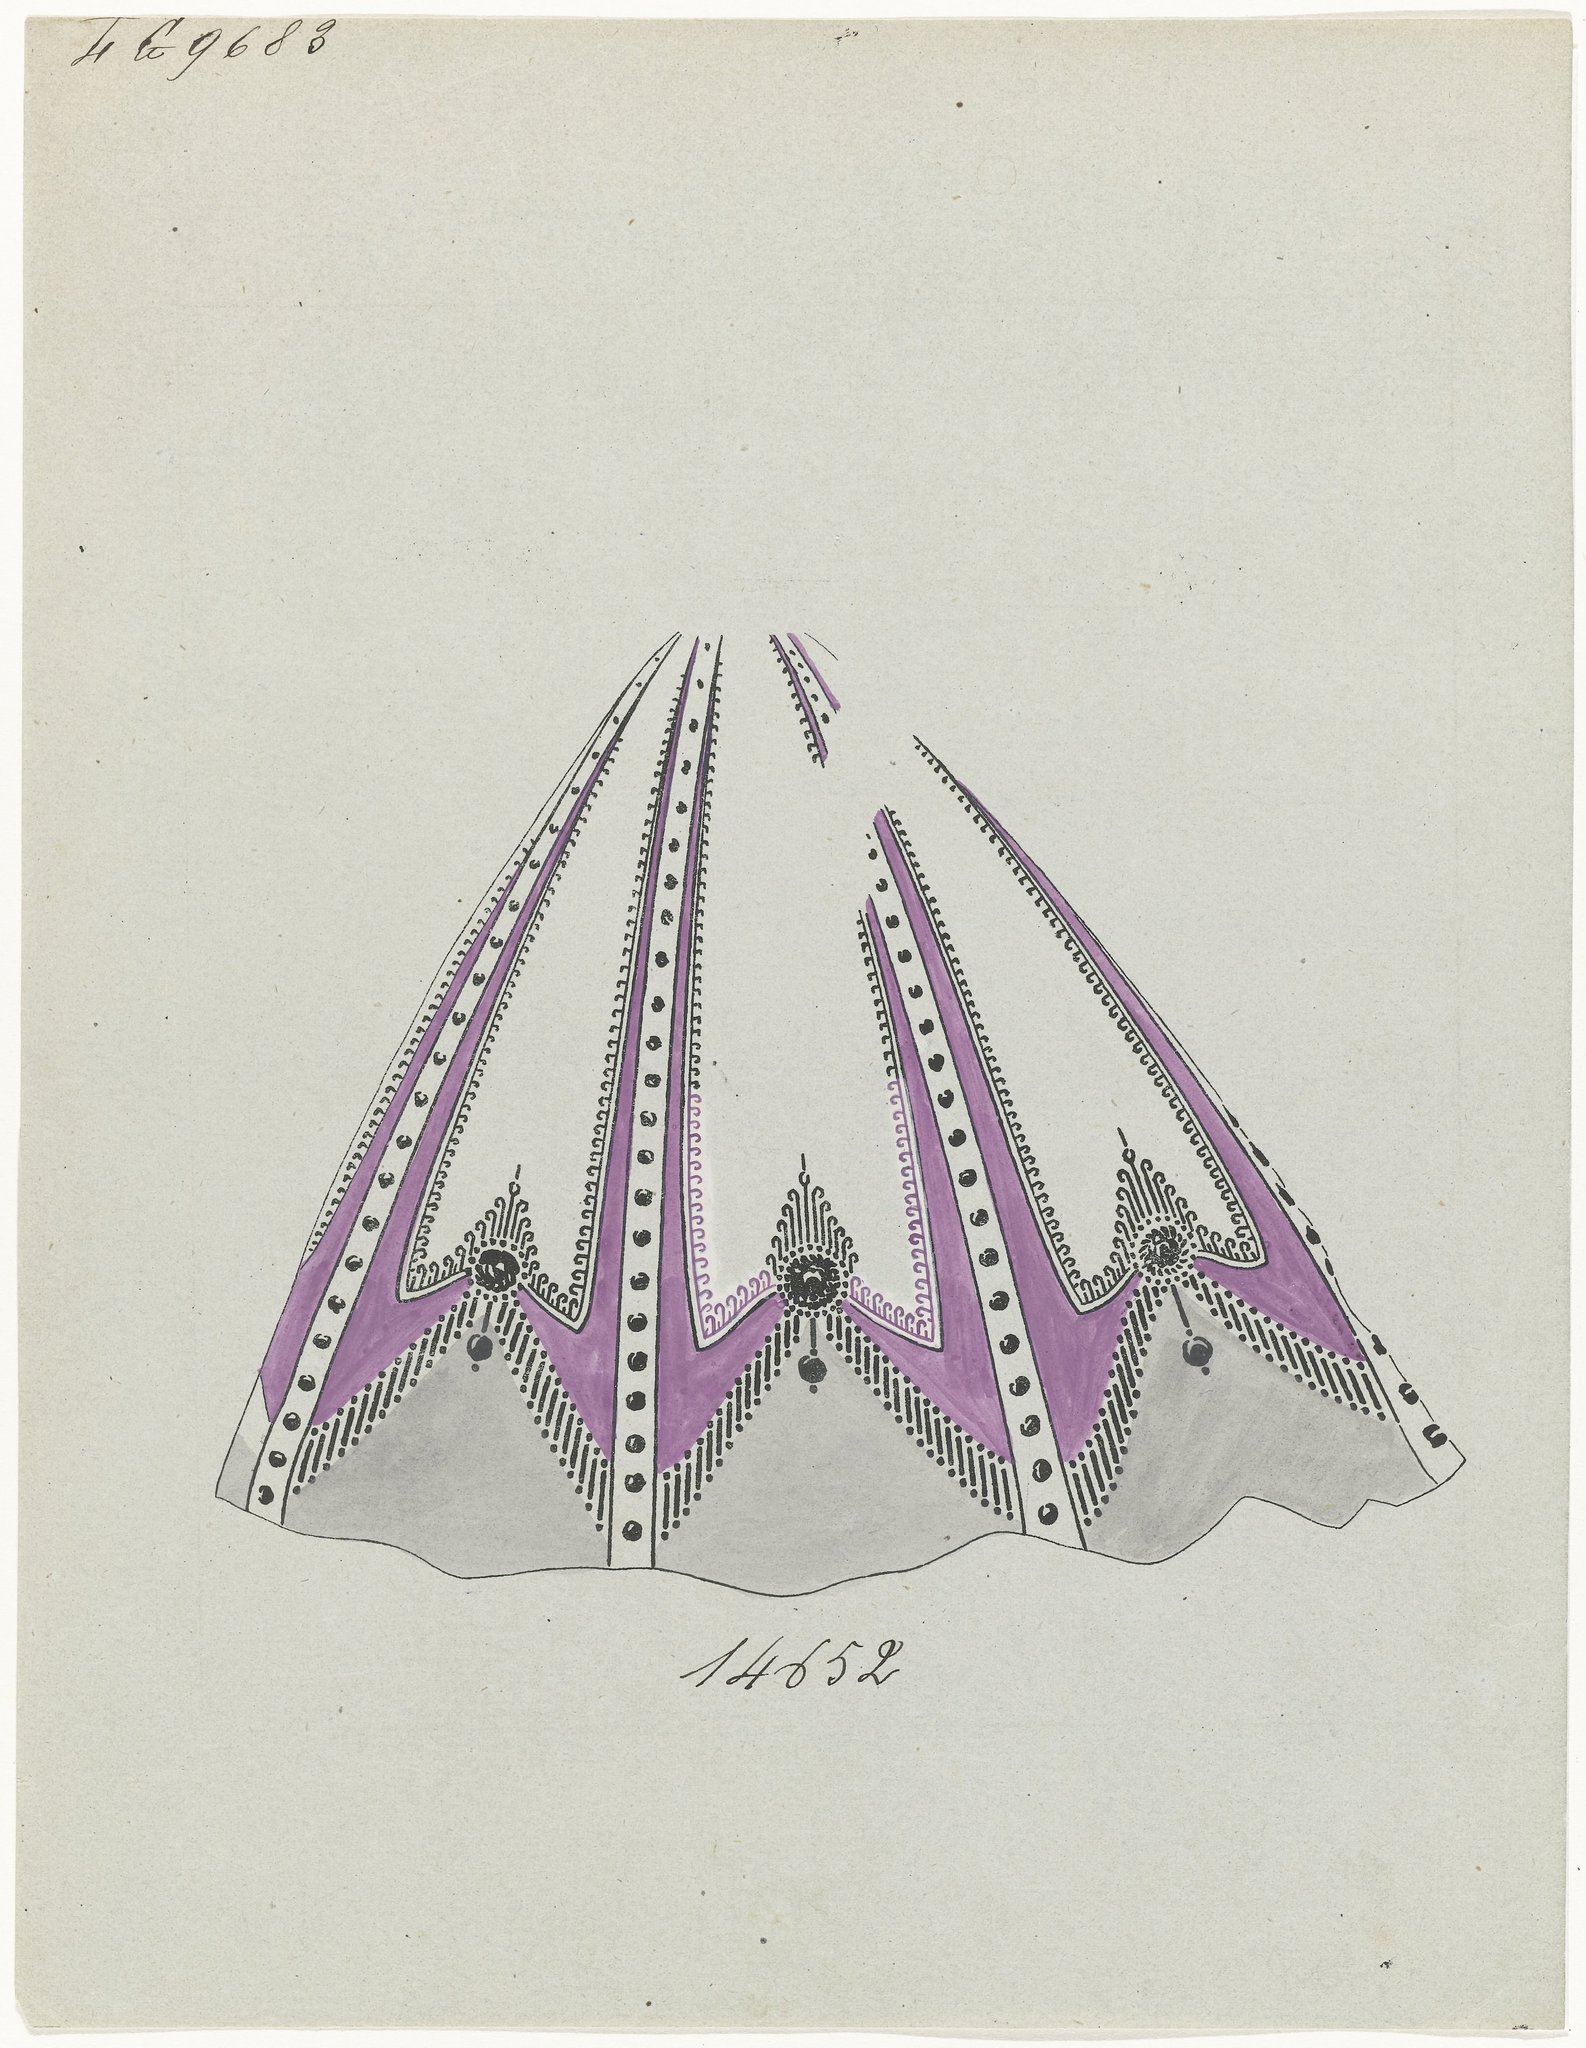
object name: watercolor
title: Wijde rok in paars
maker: Anonymous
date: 1865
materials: paper, watercolor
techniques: brush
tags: fashion plates